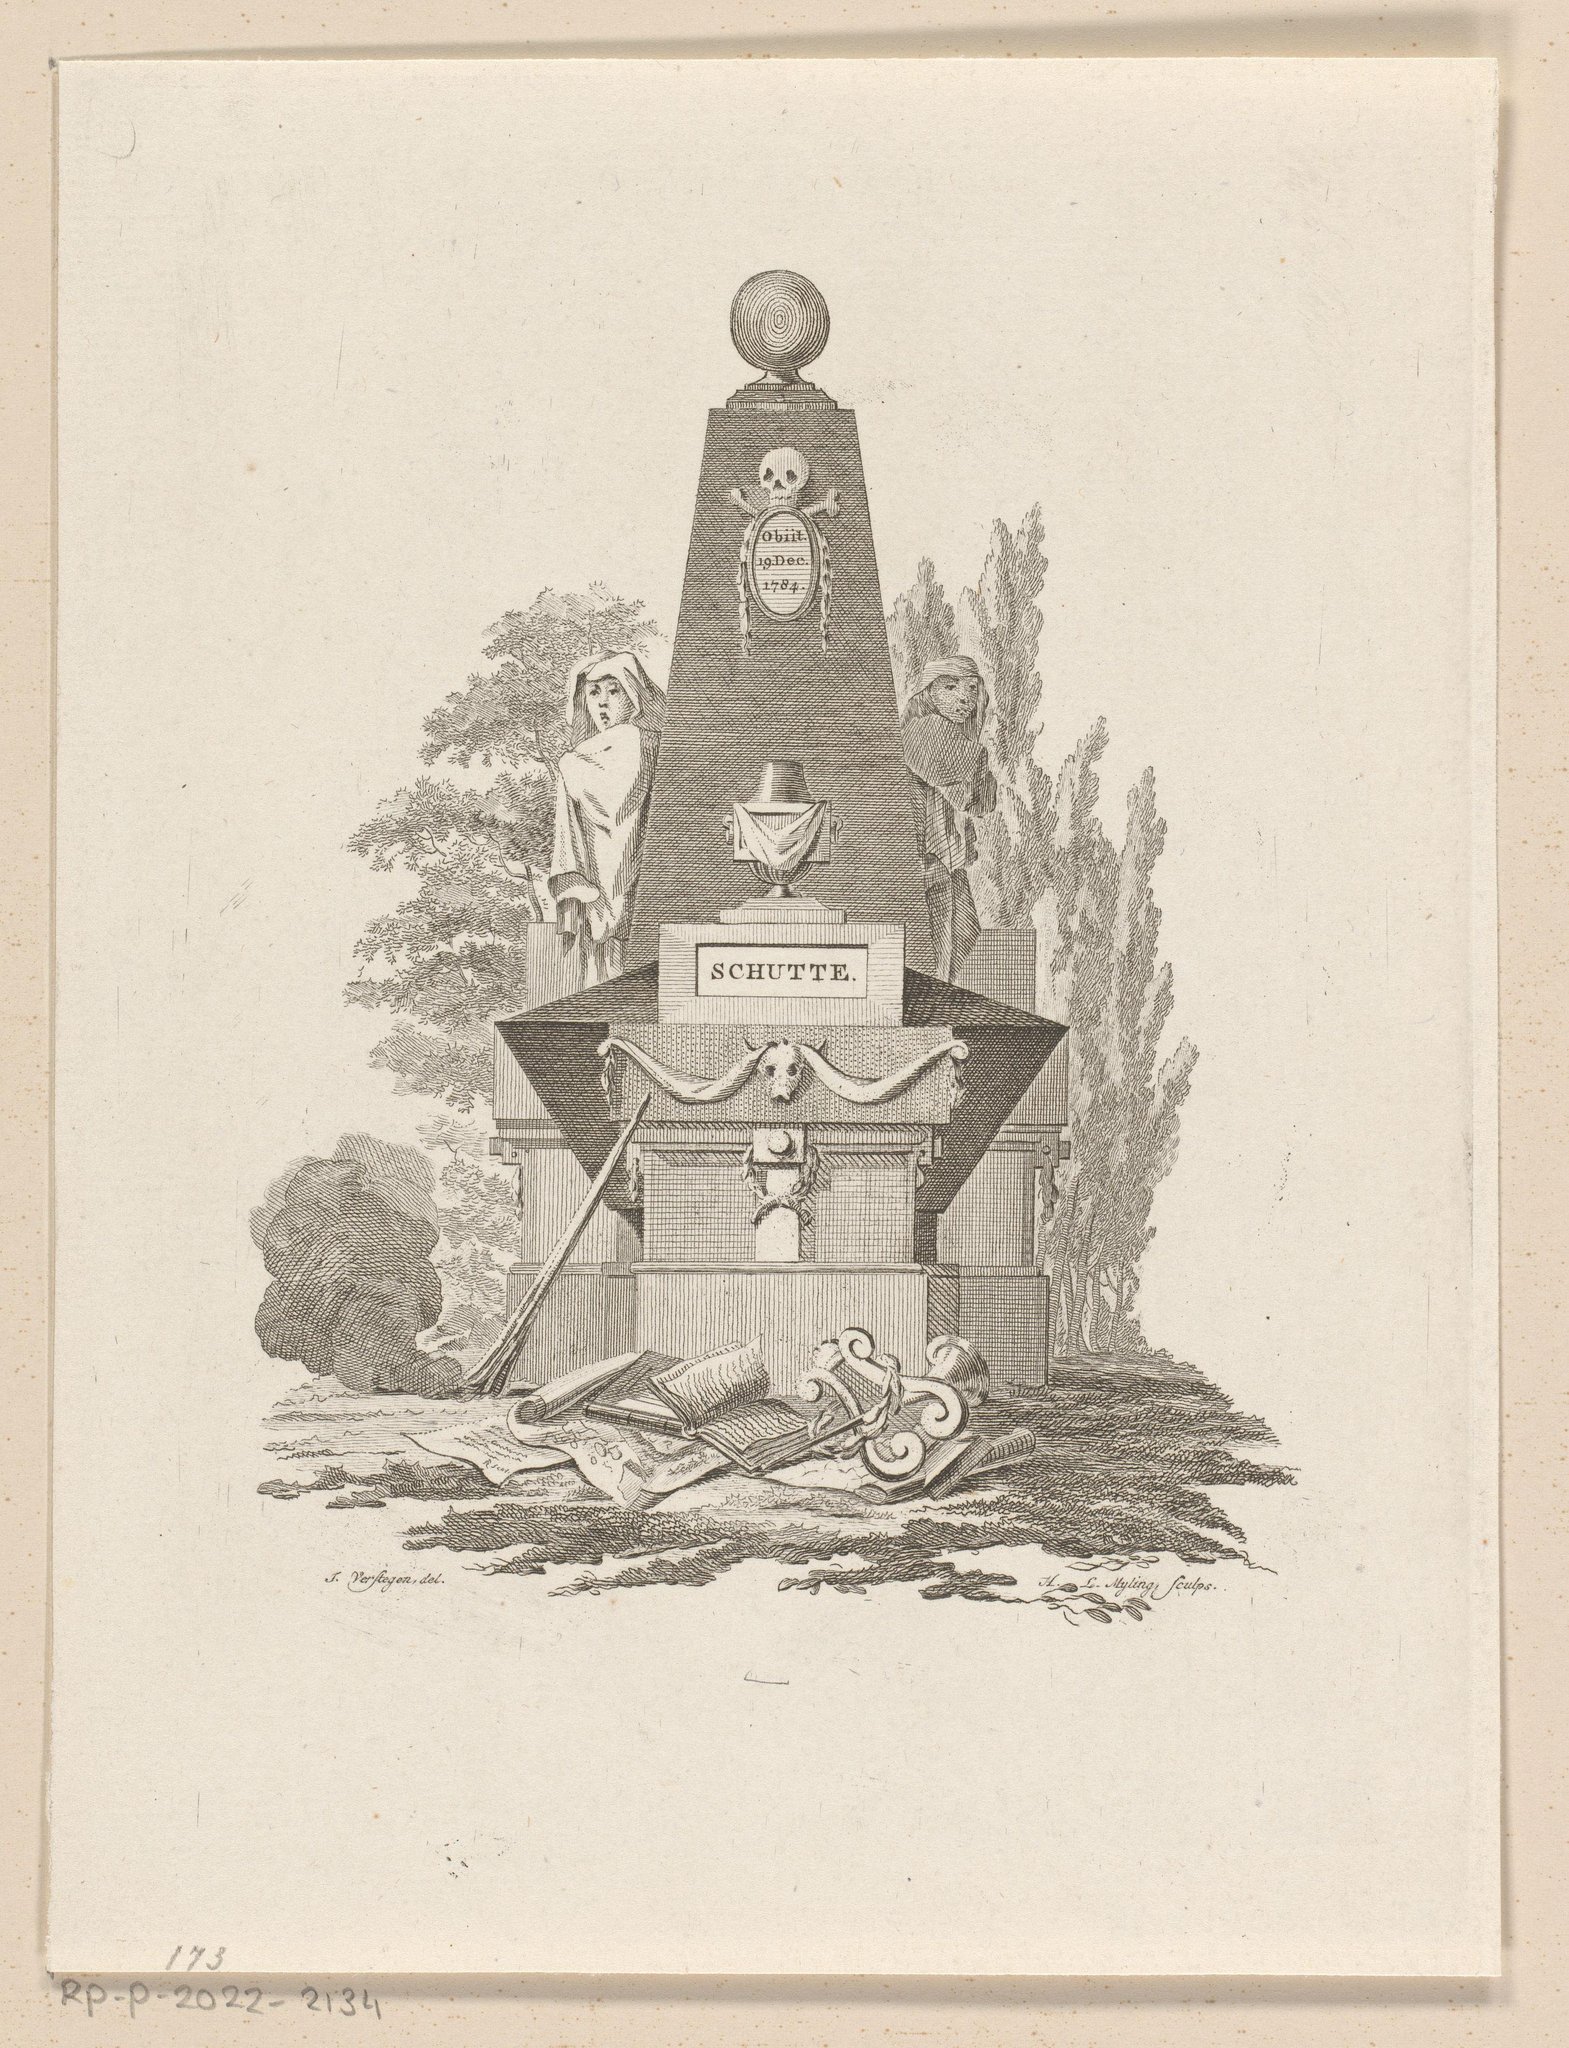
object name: print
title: Gedenkteken voor Rutger Schutte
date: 1784-1821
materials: paper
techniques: etching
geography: amsterdam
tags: amsterdam, rutger schutte, historical persons, portrait of a writer